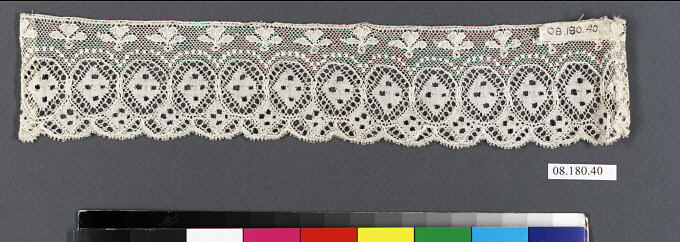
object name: piece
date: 1801-1833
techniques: lace